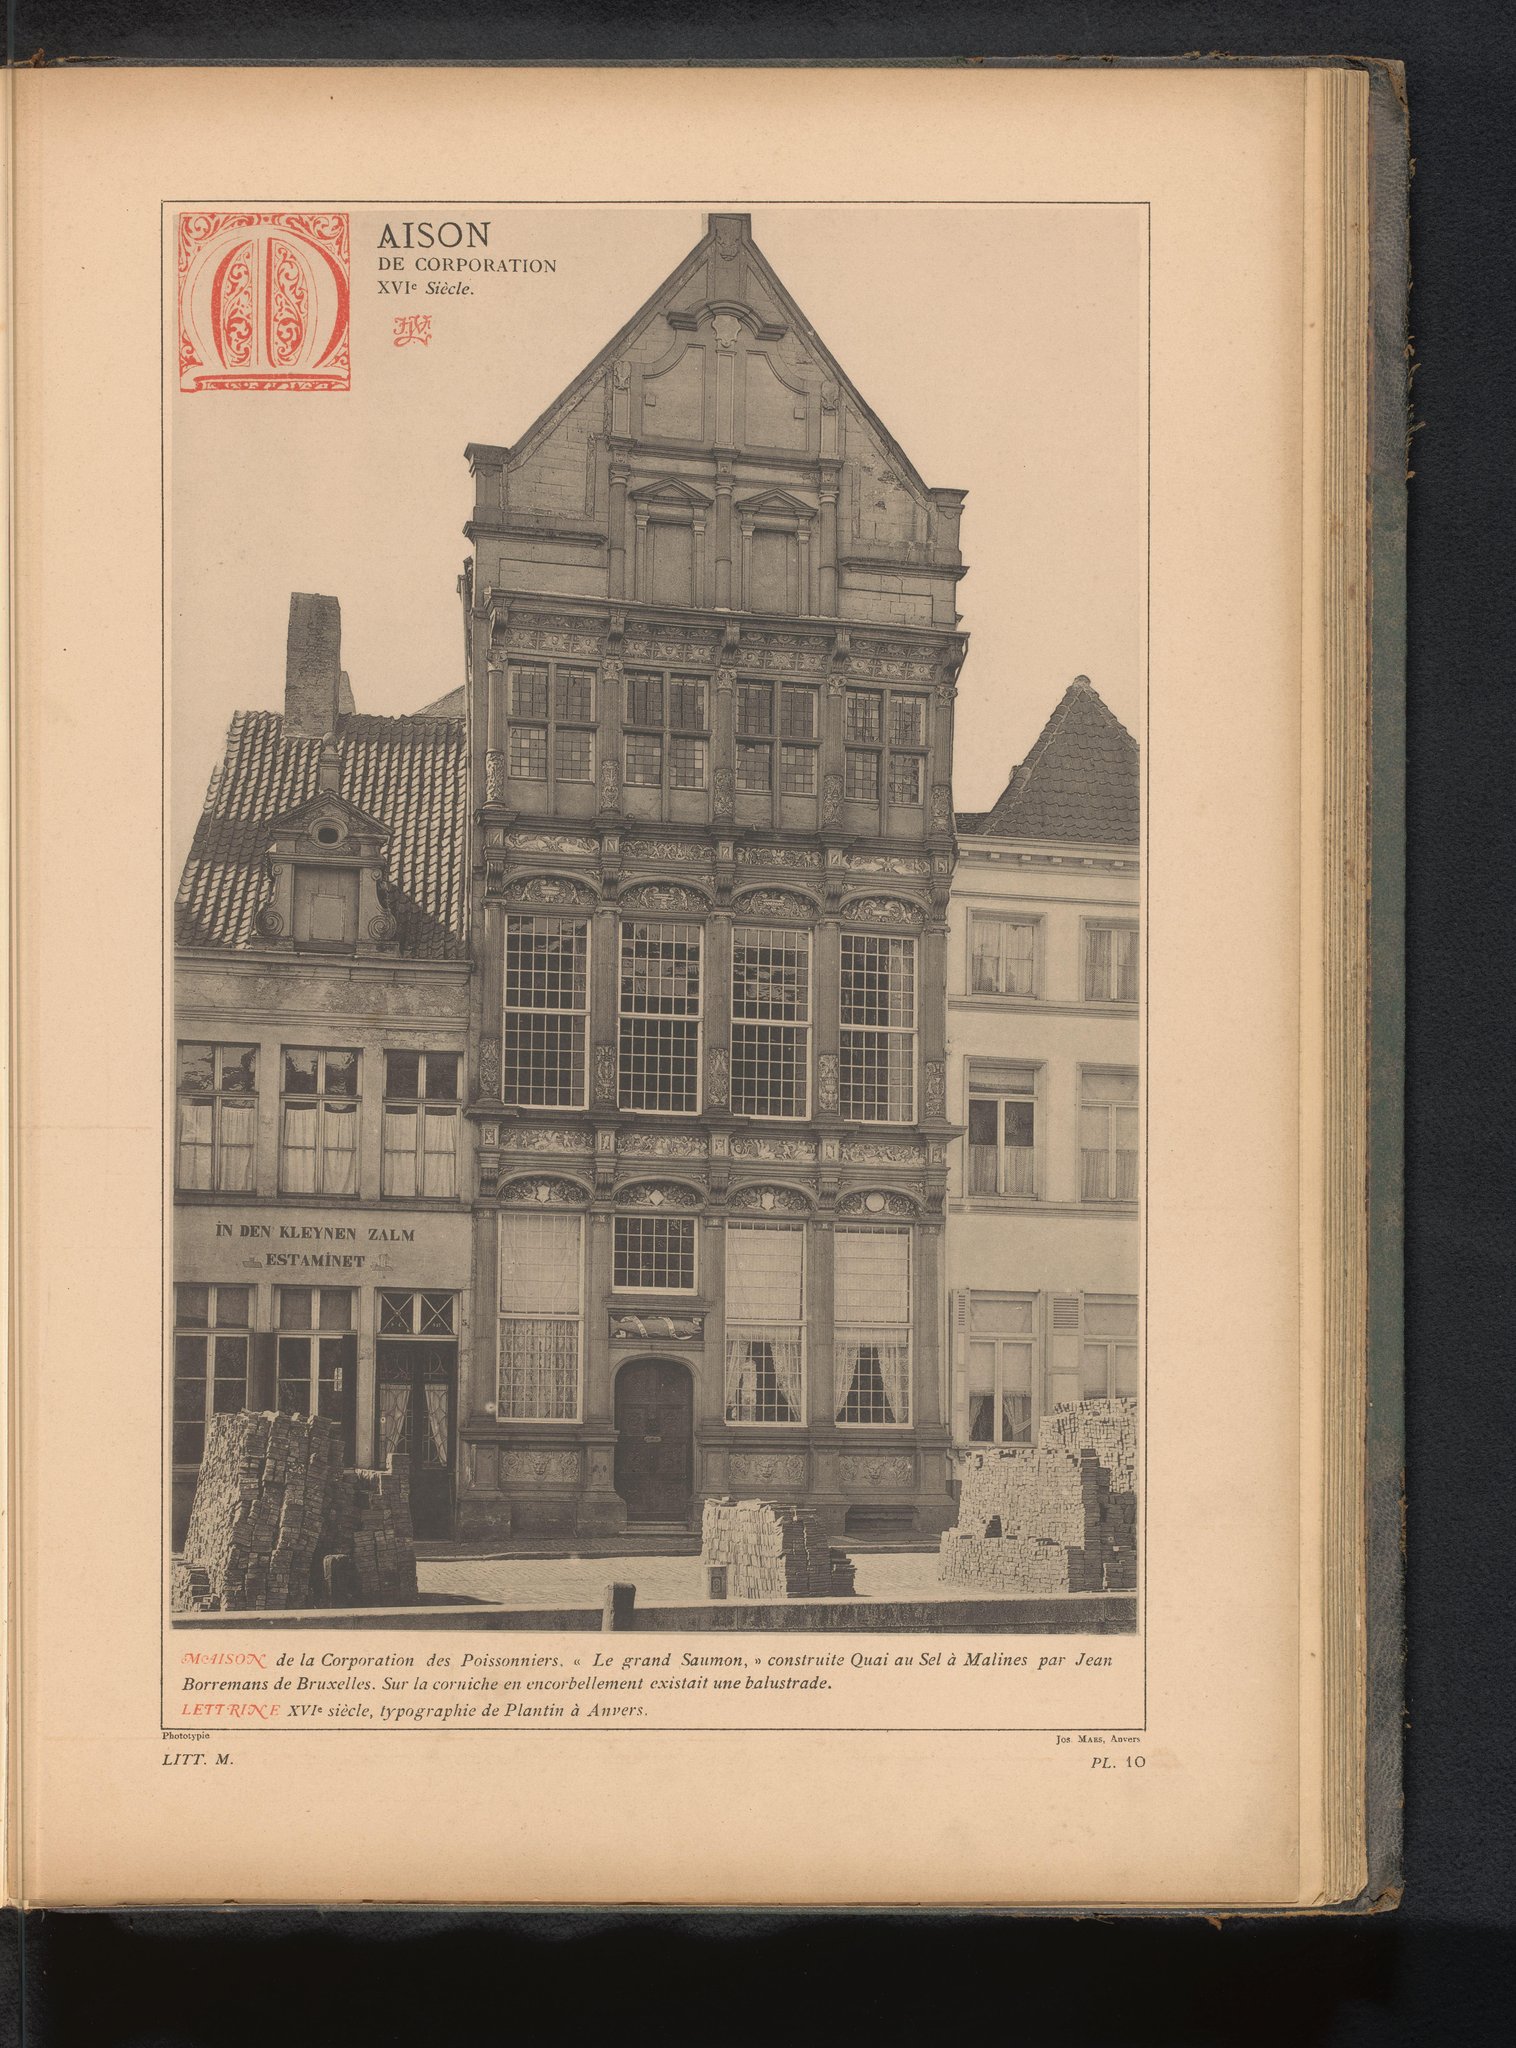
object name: page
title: Gezicht op huis De Zalm in Mechelen, België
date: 1875-1880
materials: paper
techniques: photograph, photolithography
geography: antwerp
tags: corporative organization, guild, civic architecture; edifices; dwellings, mechelen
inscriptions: inscription: ‘MAISON de la (...)’, inscription: ‘LITT. M. - PL. 10’, monogram: ‘JJvY’